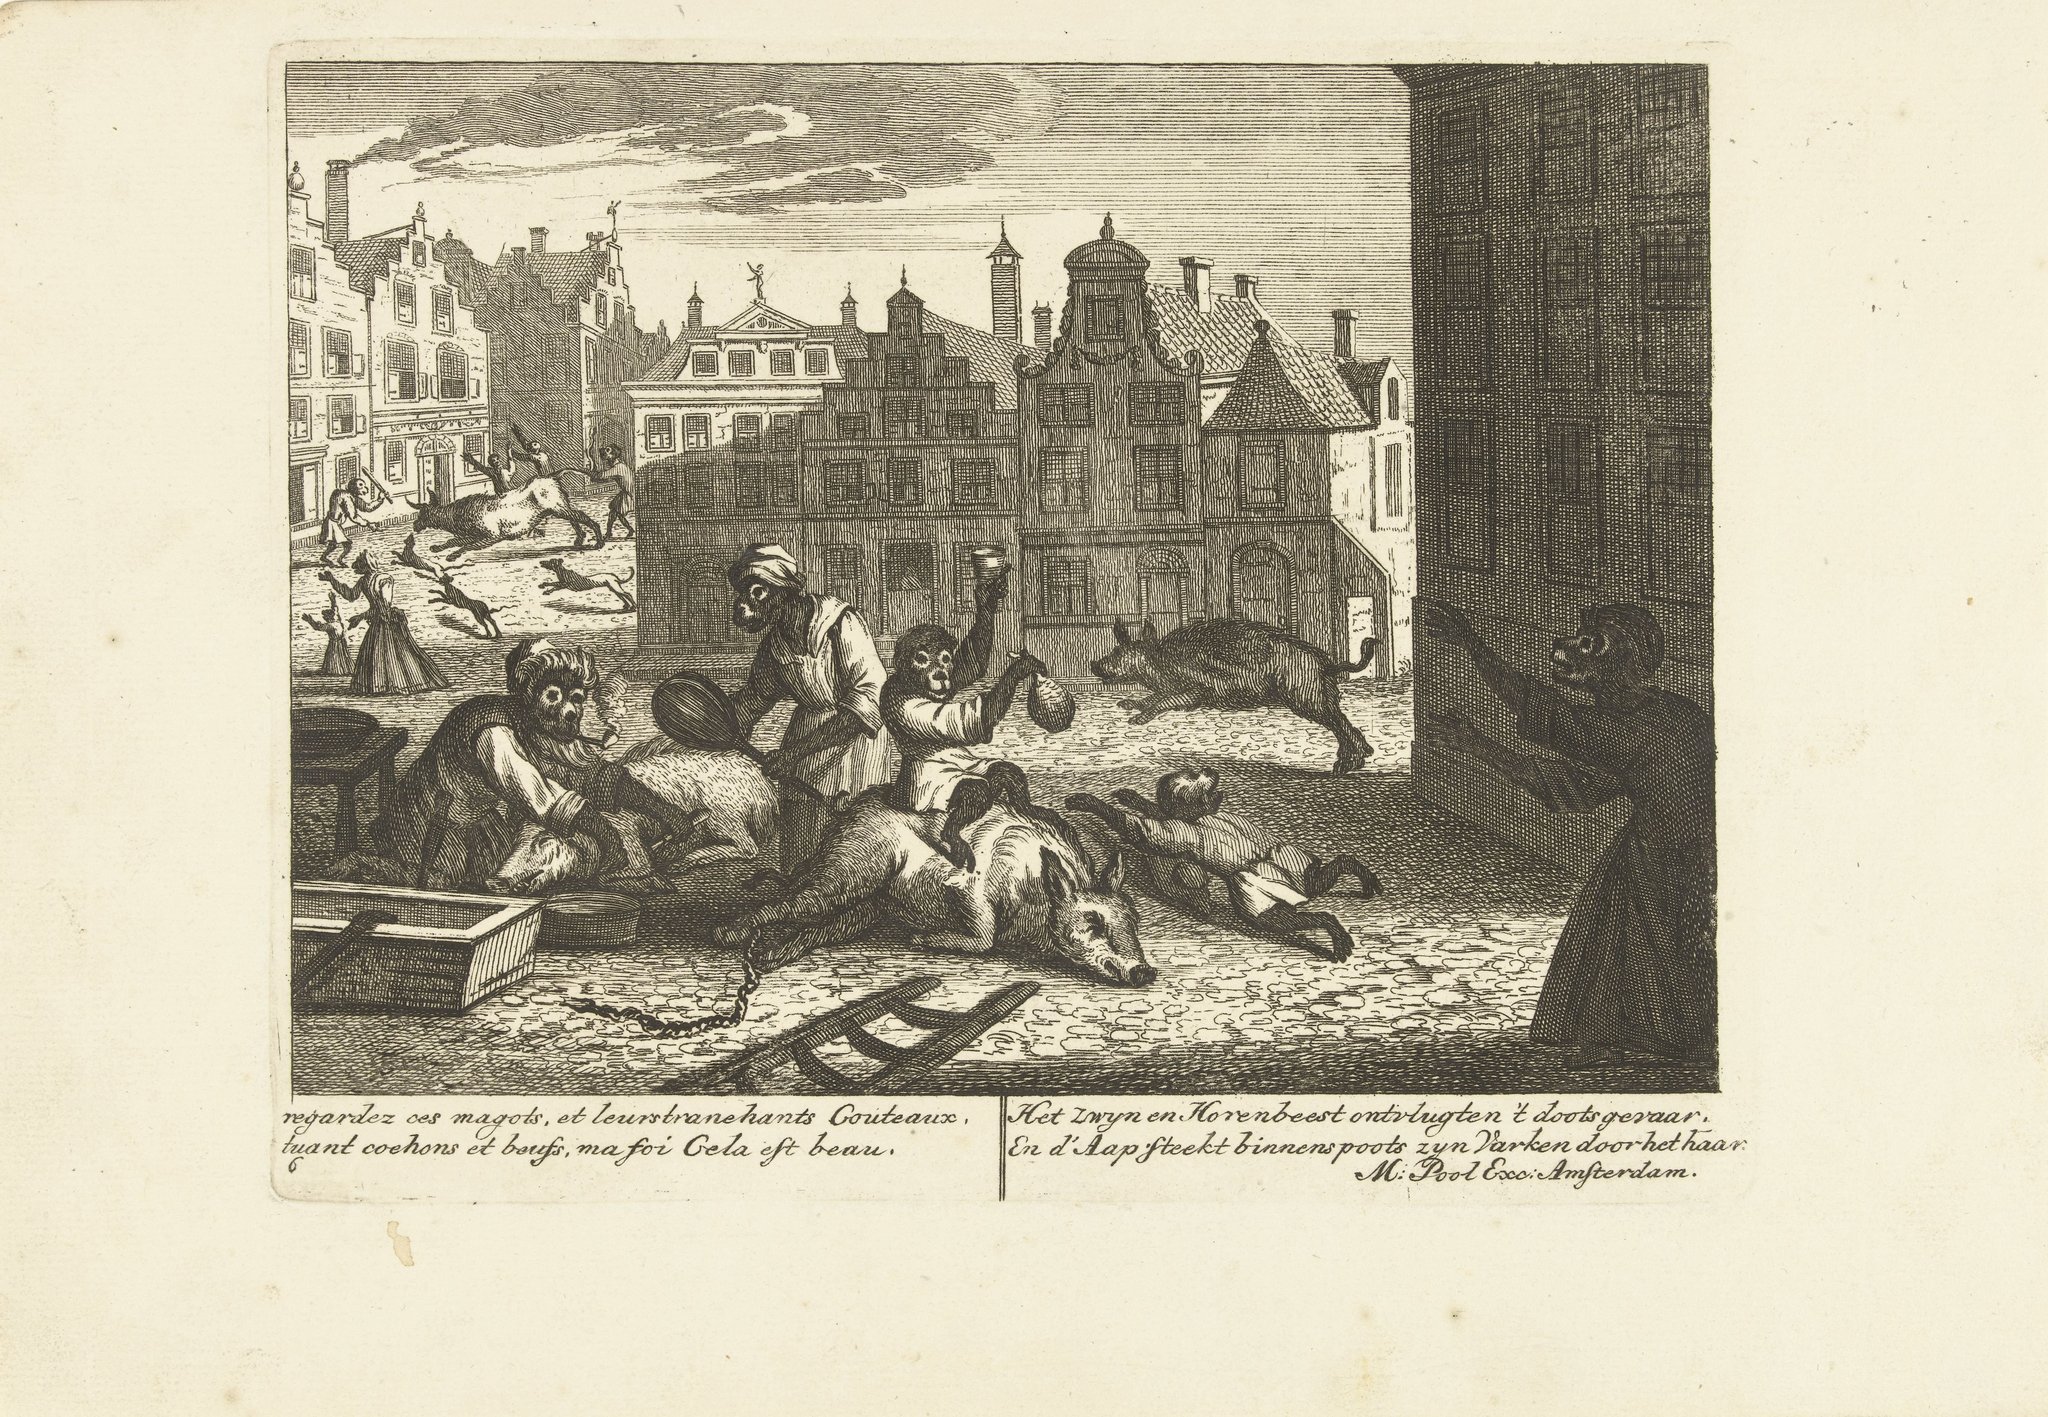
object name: print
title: Aap als slager, ca. 1720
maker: matthijs pool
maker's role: print maker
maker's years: 1676-1740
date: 1720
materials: paper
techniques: engraving, etching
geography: amsterdam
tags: monkeys, apes, animals acting as human beings, butcher, slaughterman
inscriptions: collector's mark: Lugt 2228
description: Apen die varkens aan het slachten zijn, op de achtergrond een ontsnapt rund. In het onderschrift versjes in het Frans en Nederlands. Prent nr. 6 in een serie van 16 prenten van ca. 1720 waarin apen als mensen figureren in allerlei huishoudelijke taferelen.